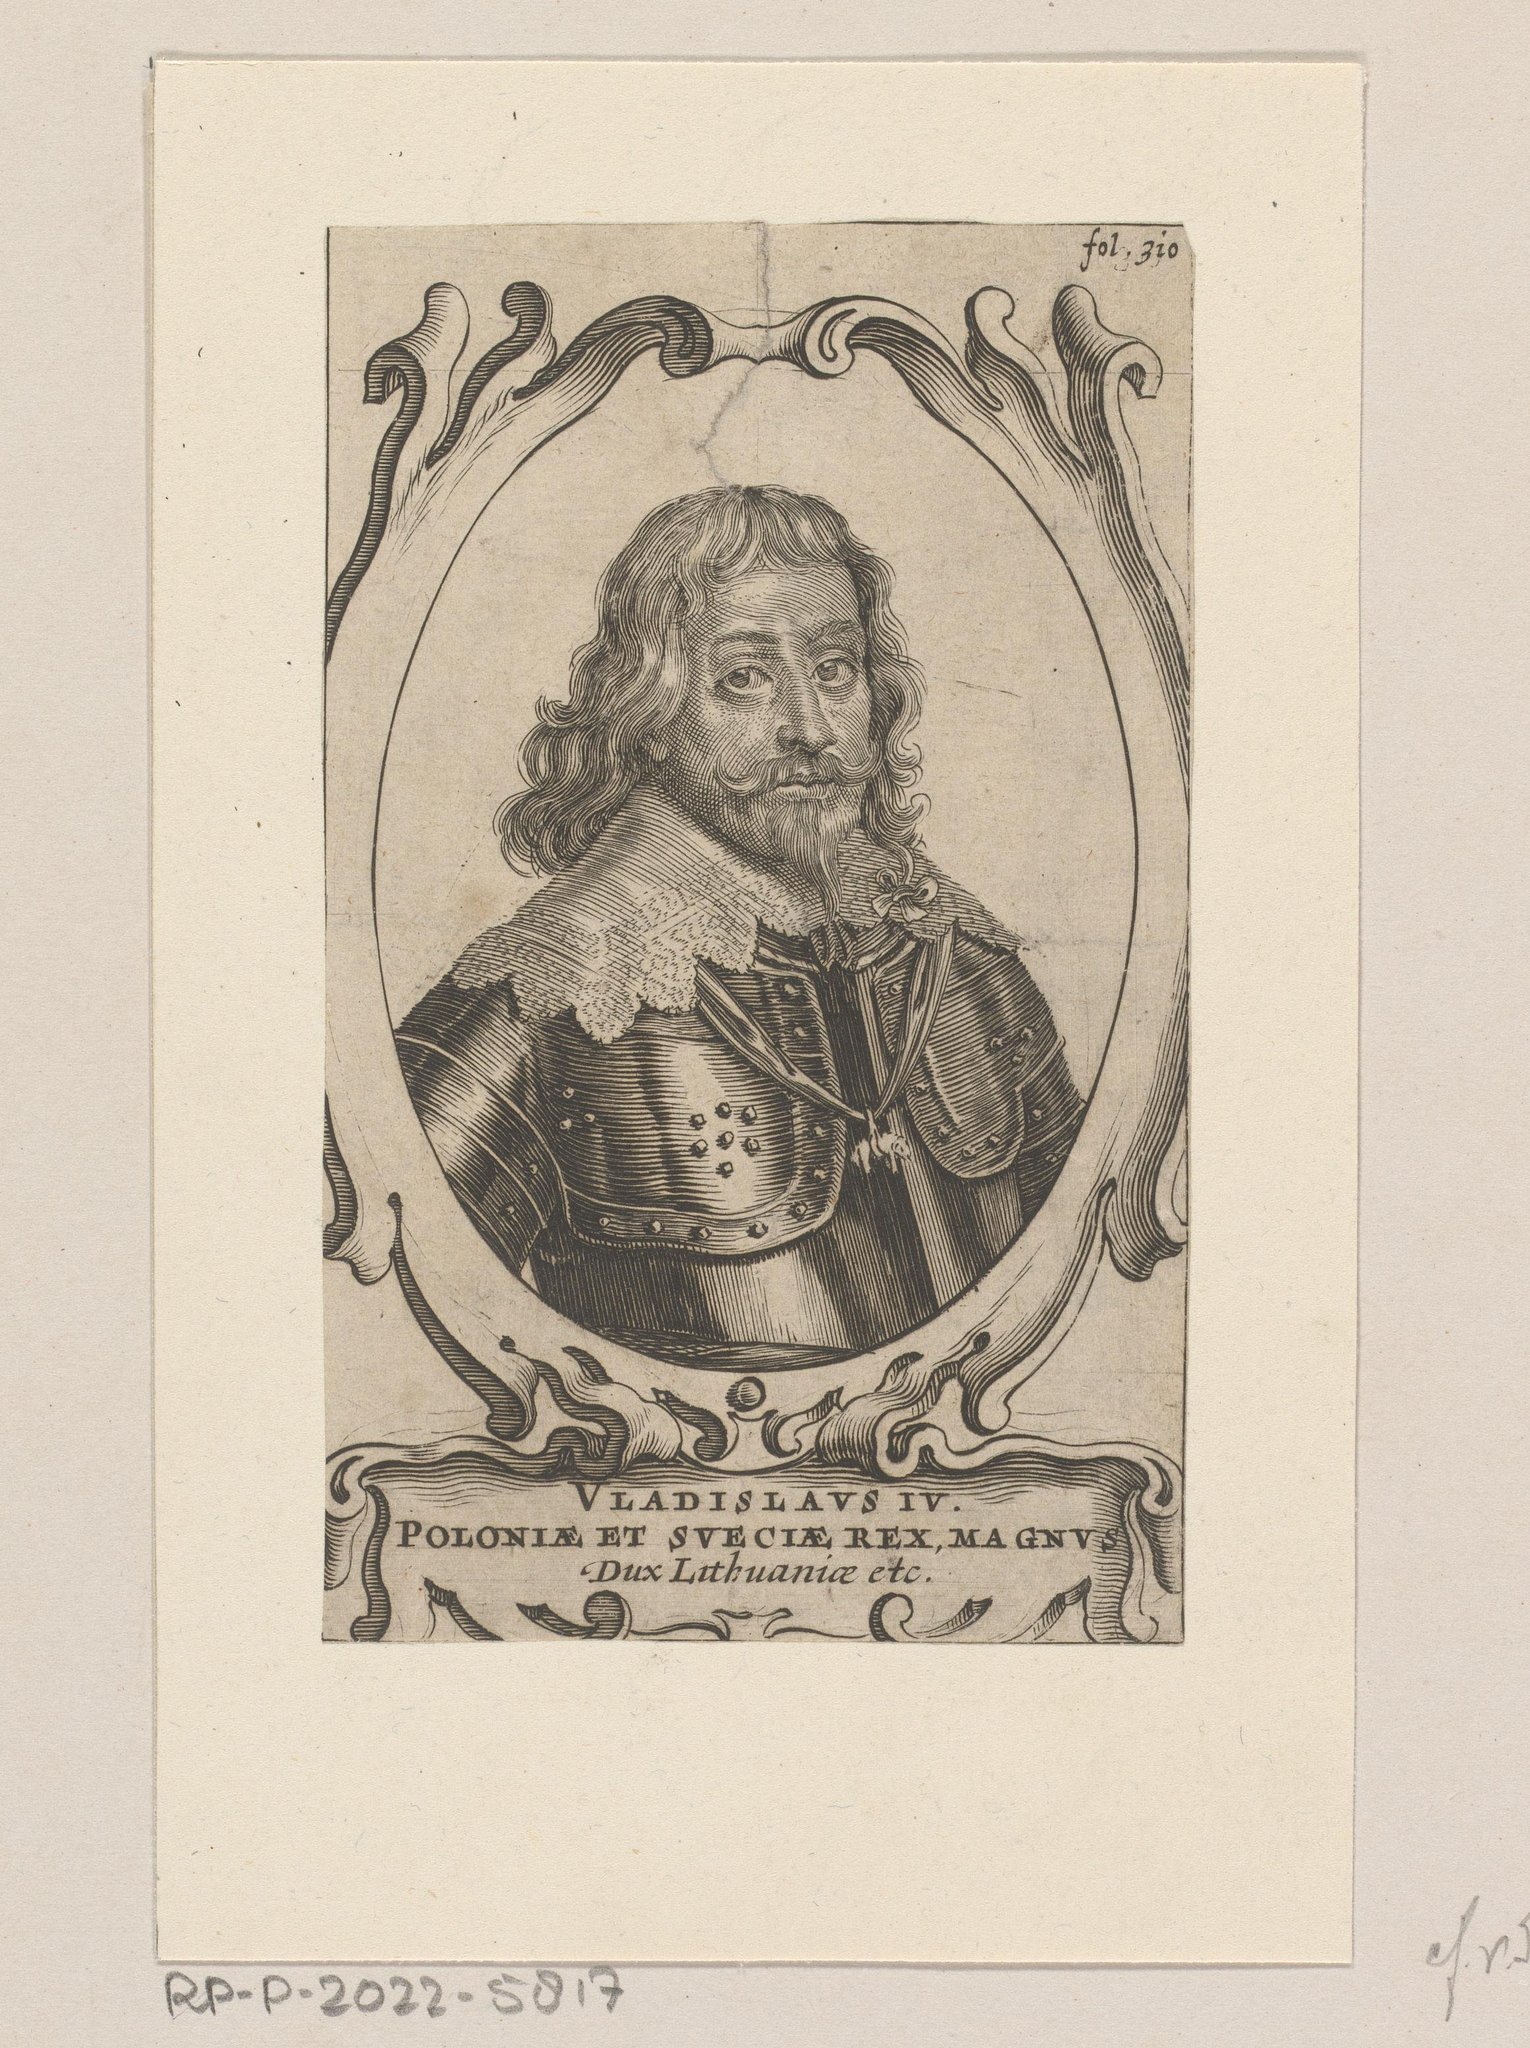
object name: book illustration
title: Portret van Wladislaus IV van Polen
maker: Anonymous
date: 1656-1666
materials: paper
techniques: engraving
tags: wladislaus wasa (iv), historical persons, knighthood order of the golden fleece, ruler, sovereign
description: Prent waarschijnlijk uit: Brachelius, Johannes Adolphus. Historia nostri temporis, dat is geschiedenis onses tijdts (…). Rotterdam: Andries van Hoogenhuysen, 1656. Prent ook gebruikt in de 1659- en 1666-editie.